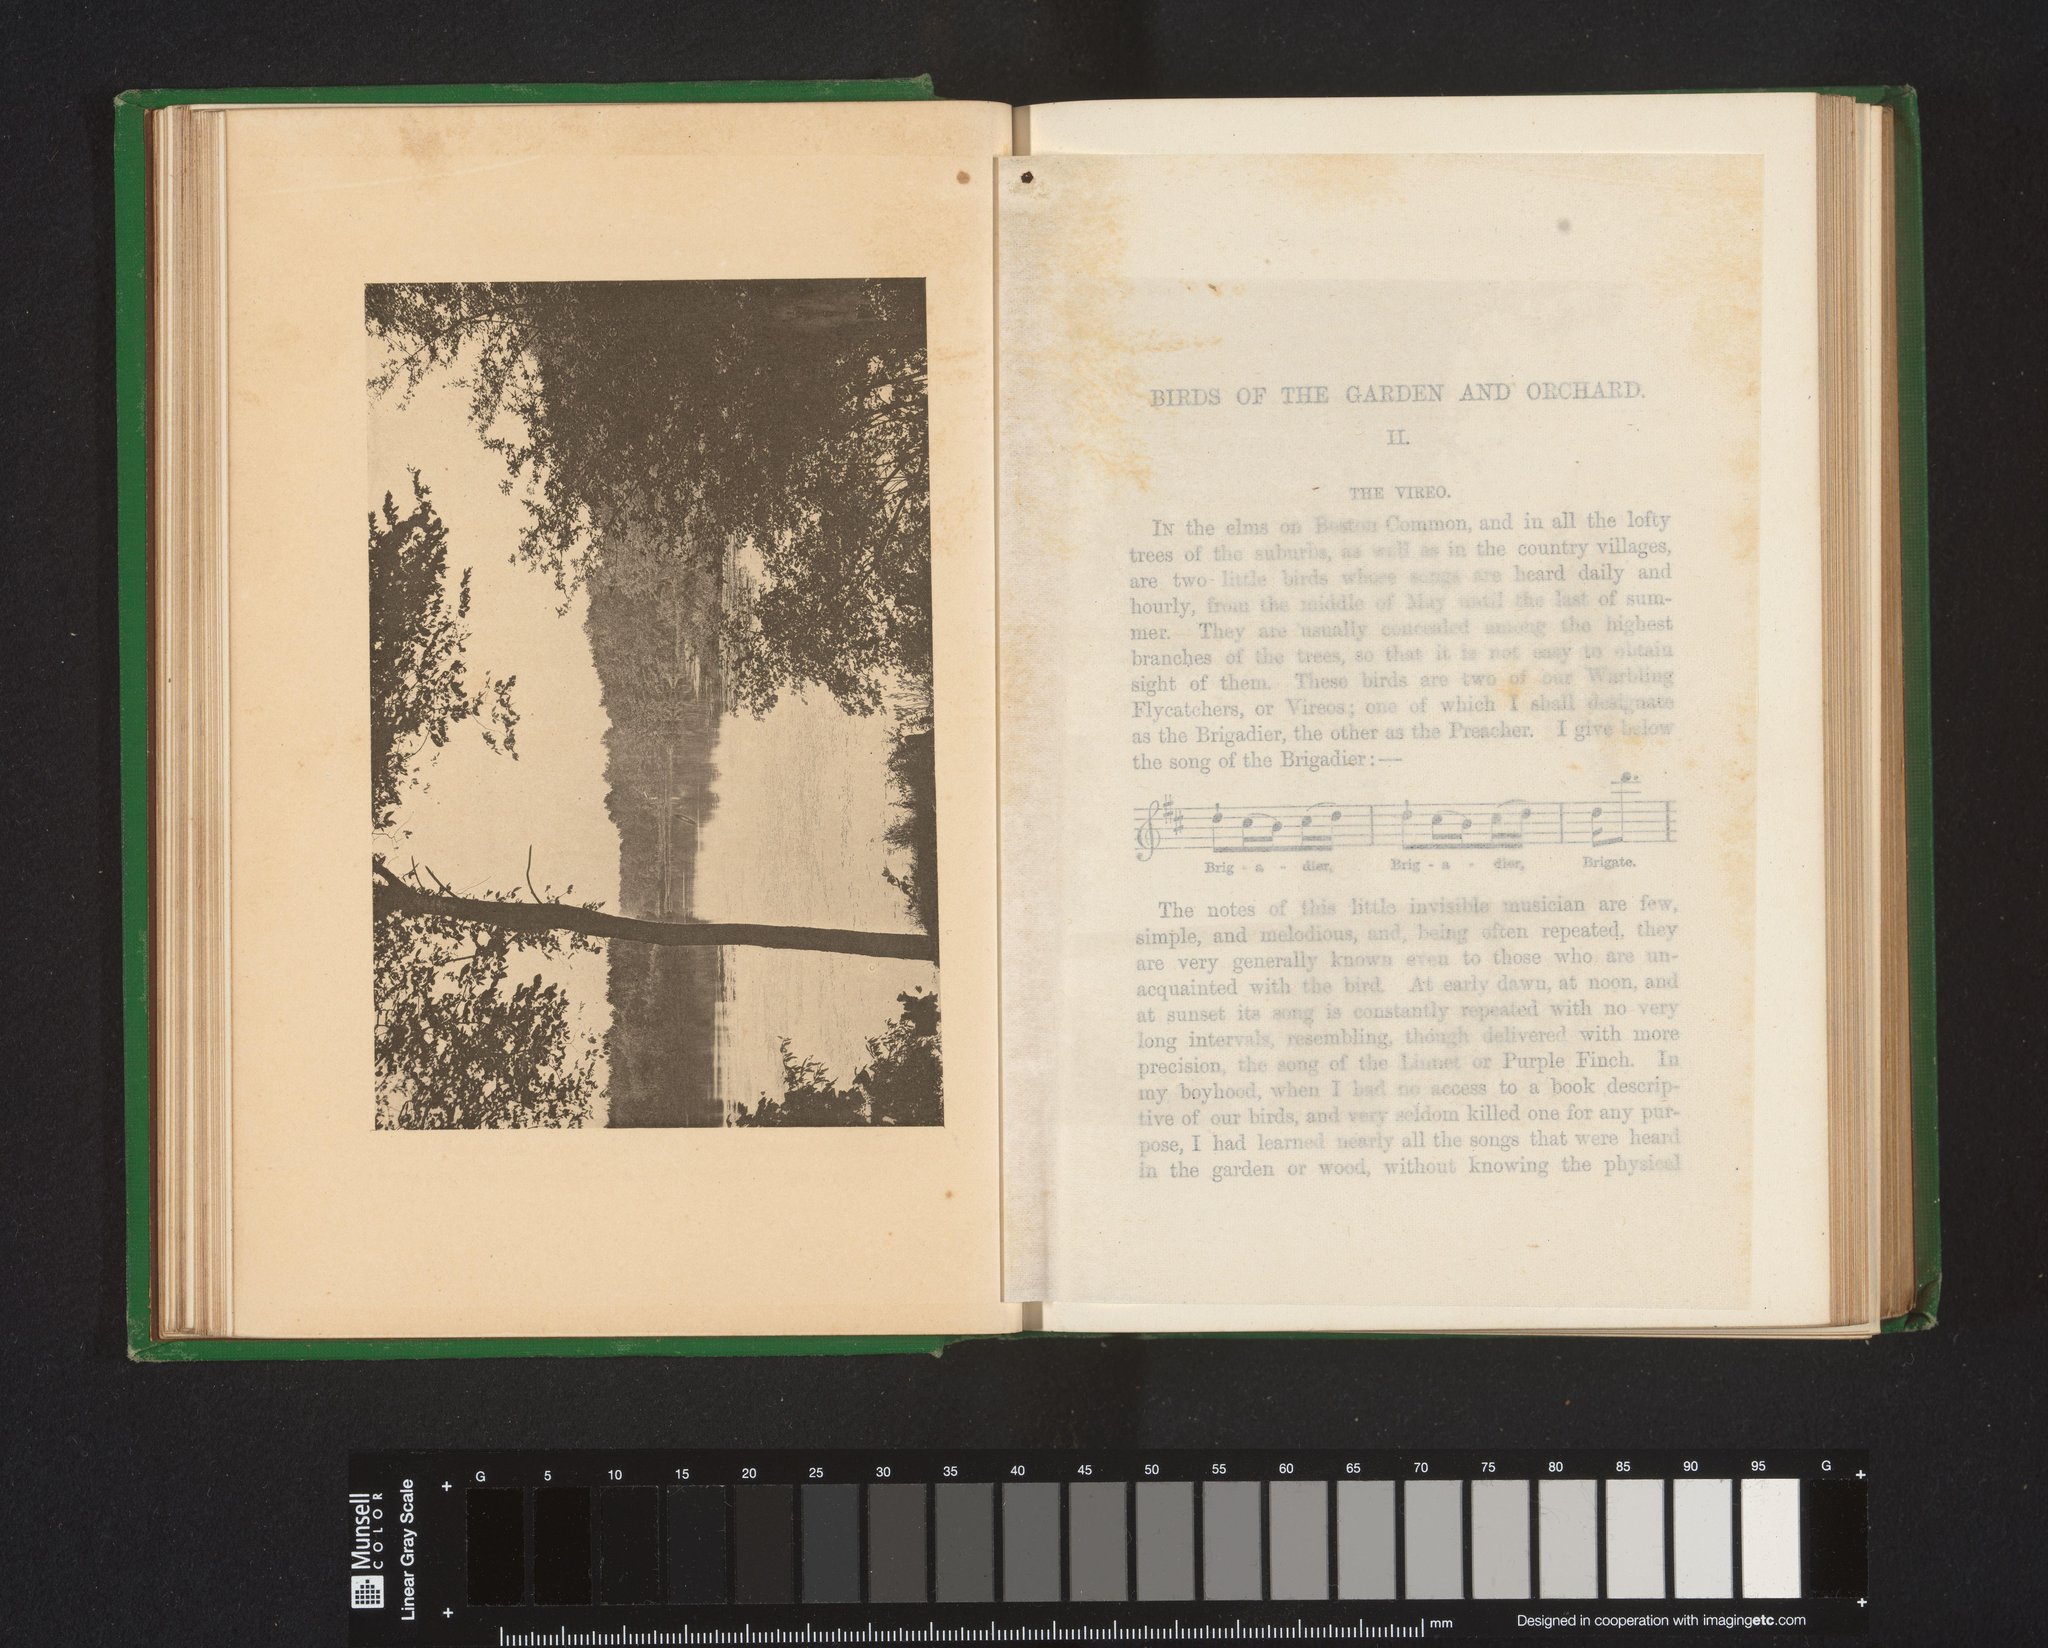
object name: page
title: Gezicht op de Charles te Massachusetts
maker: Anonymous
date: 1875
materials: paper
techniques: photograph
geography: auburndale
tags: trees, river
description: Prent op tweede ongenummerde pagina na pagina 42.